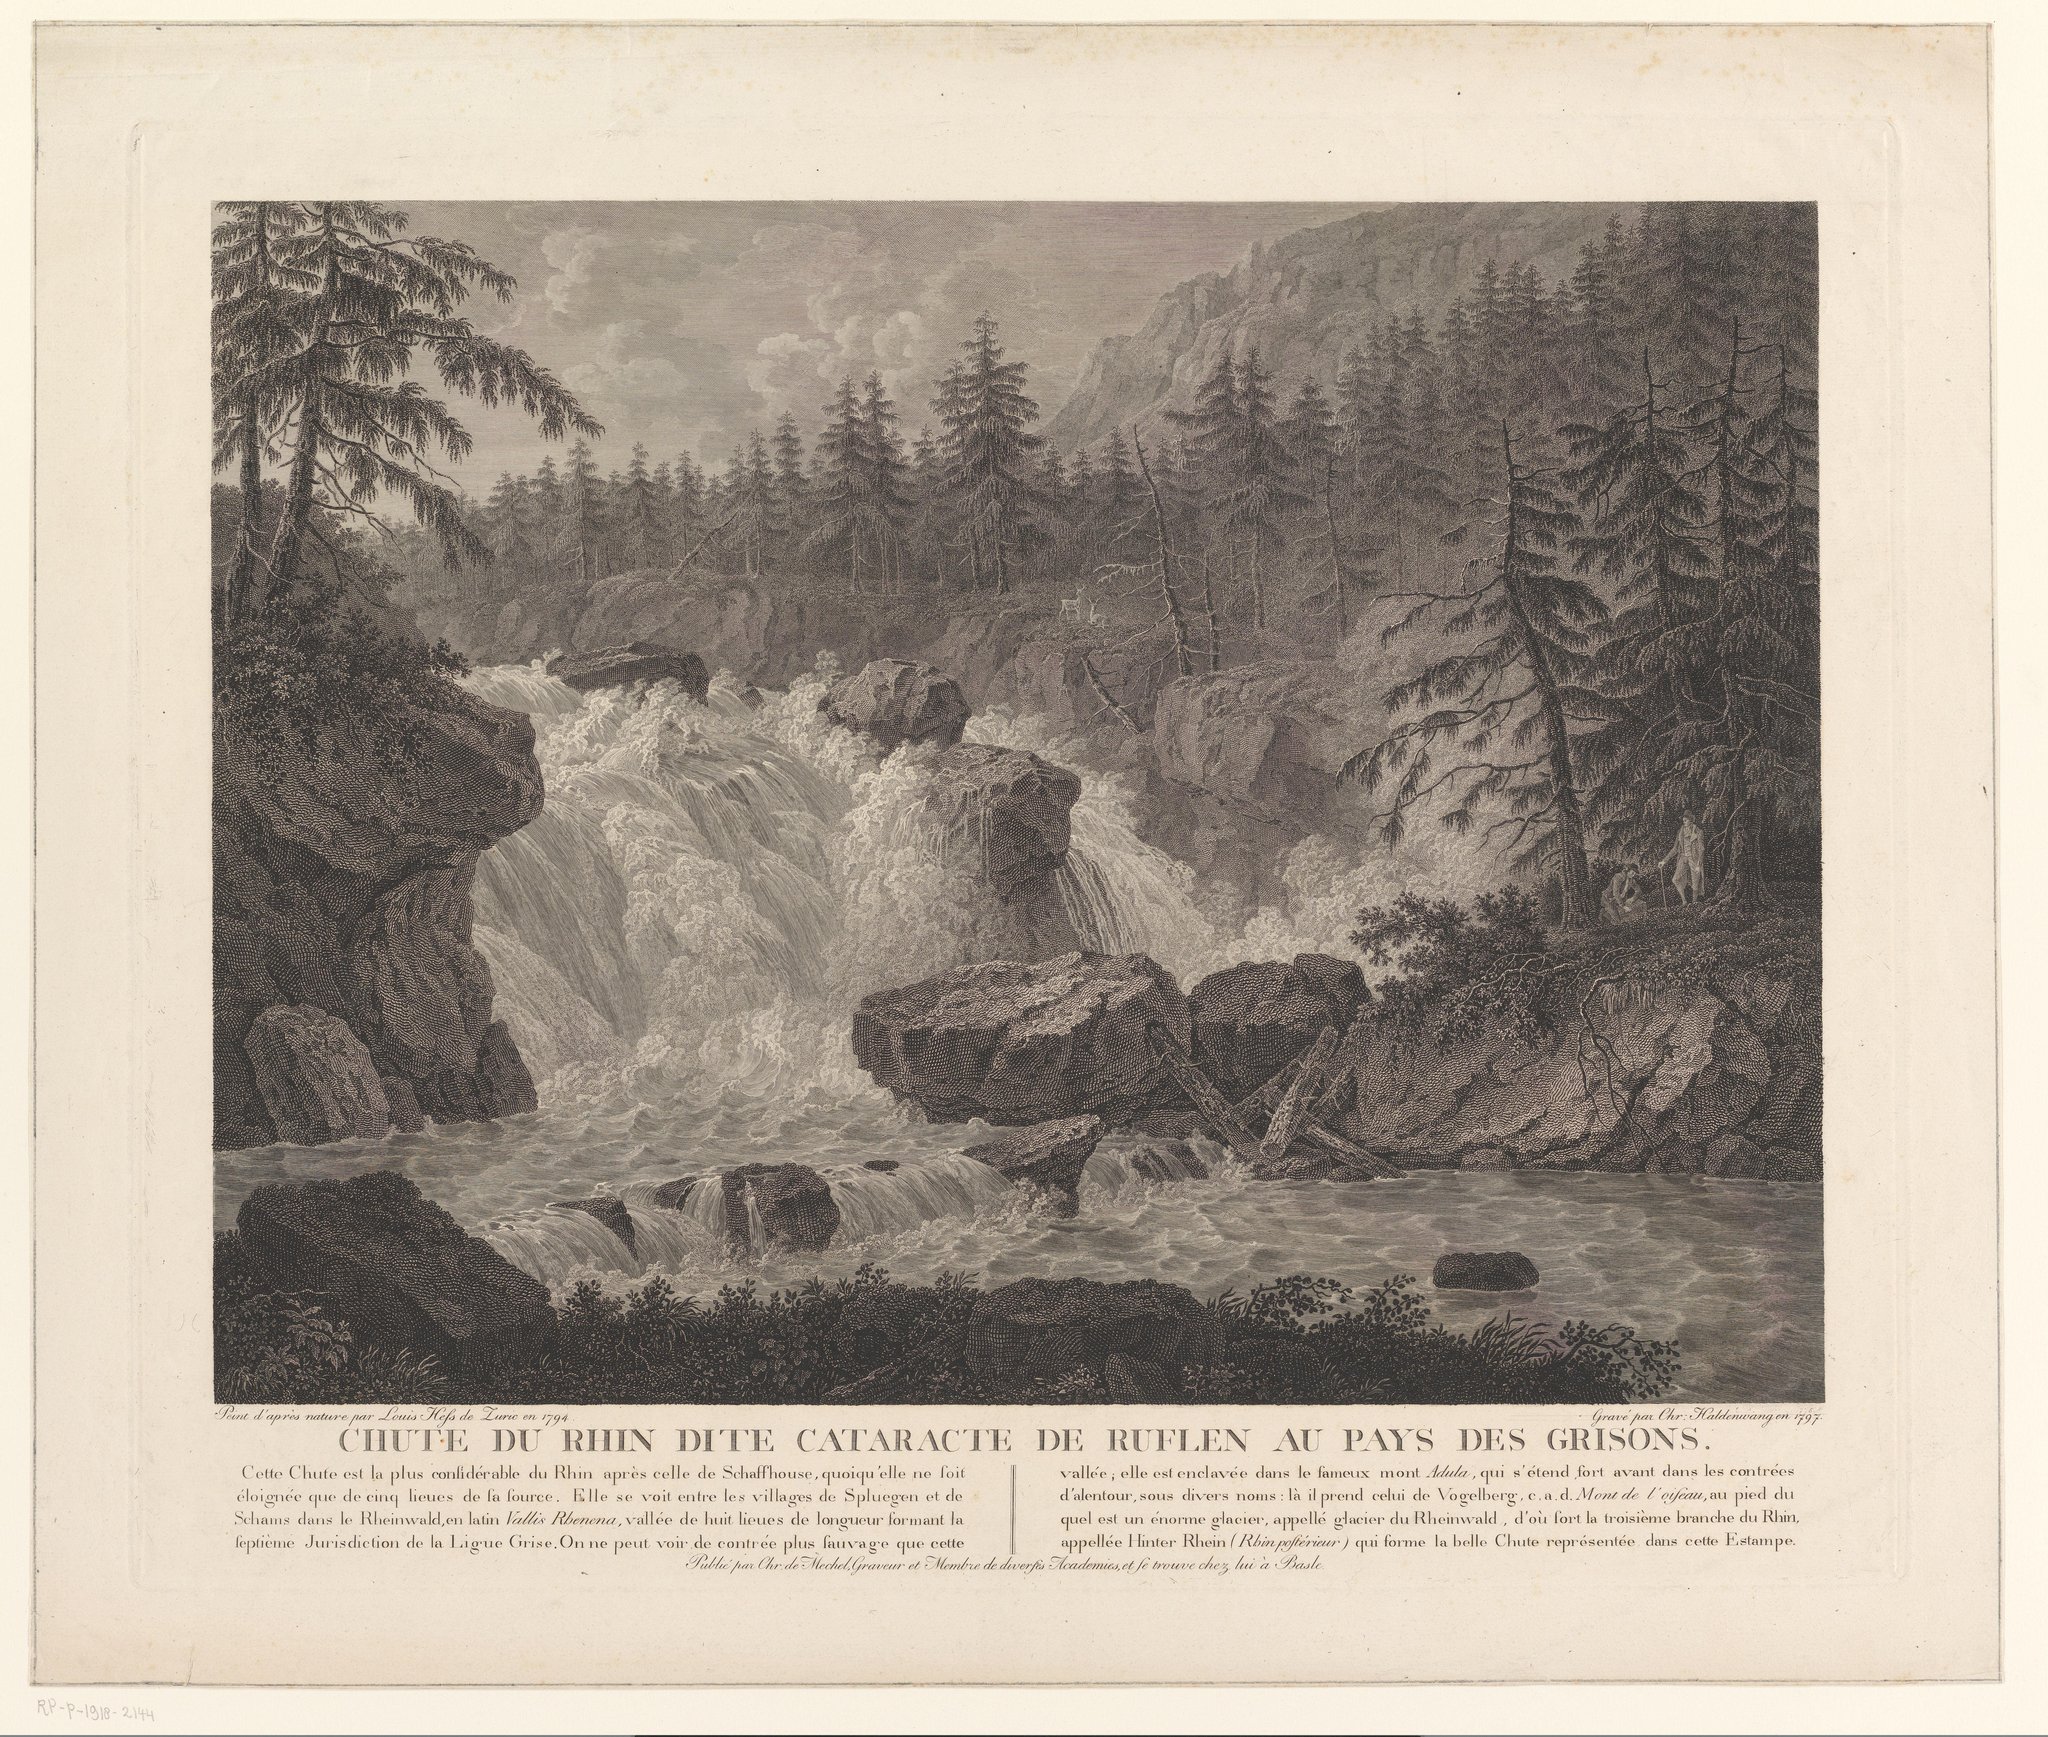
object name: print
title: Gezicht op de Rijnval in Graubünden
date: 1797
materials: paper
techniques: etching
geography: zurich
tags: rapids, waterfall (+ landscape with figures, staffage)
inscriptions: collector's mark: Lugt 2233